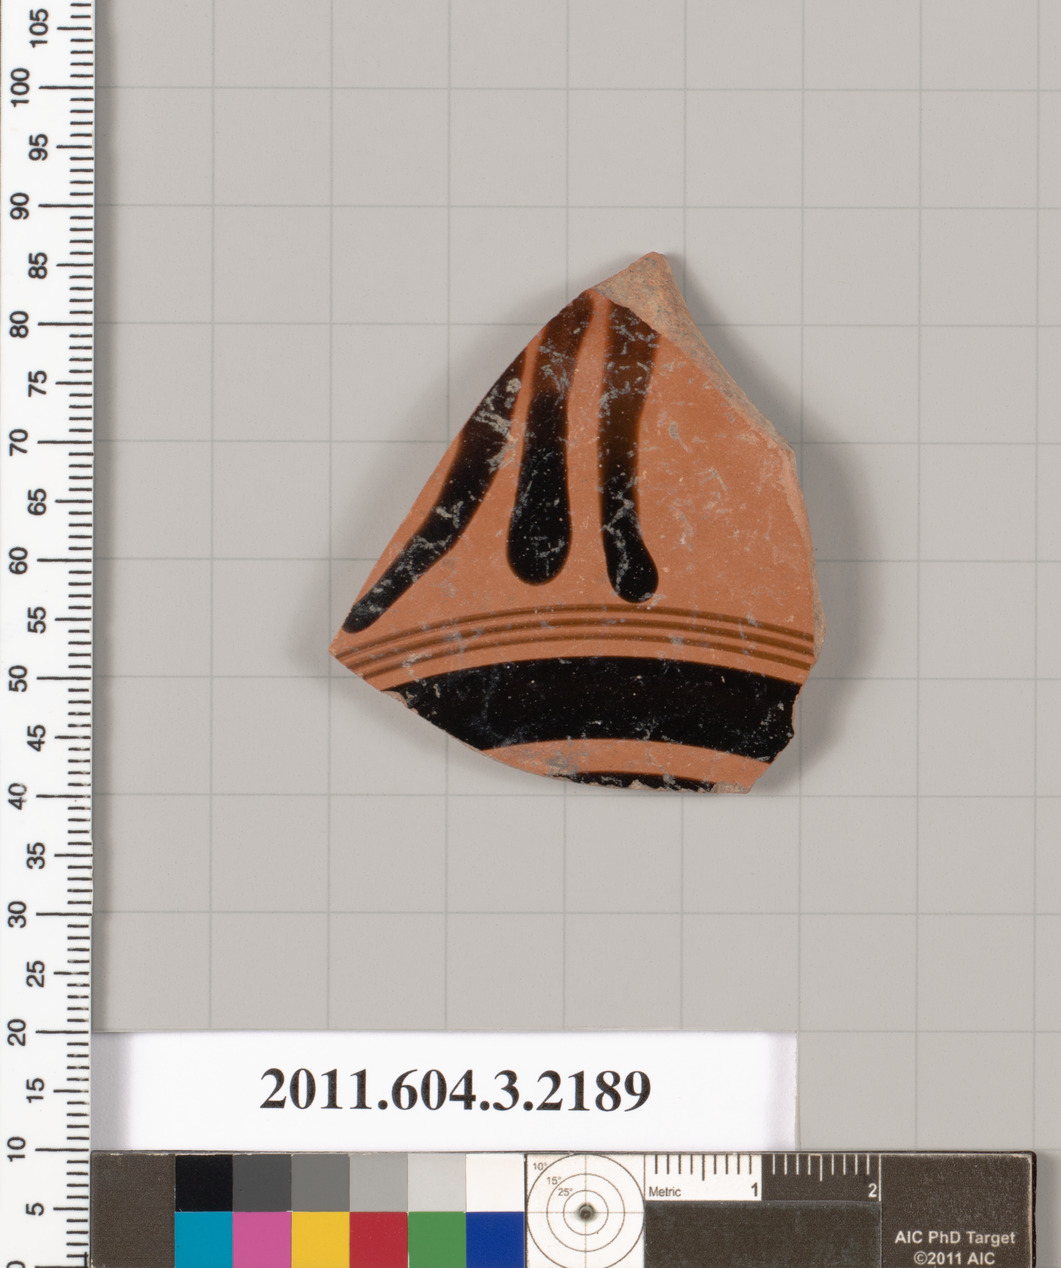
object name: kylix fragment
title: Terracotta fragment of a kylix (drinking cup)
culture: greek, attic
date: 500-468 BCE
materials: terracotta